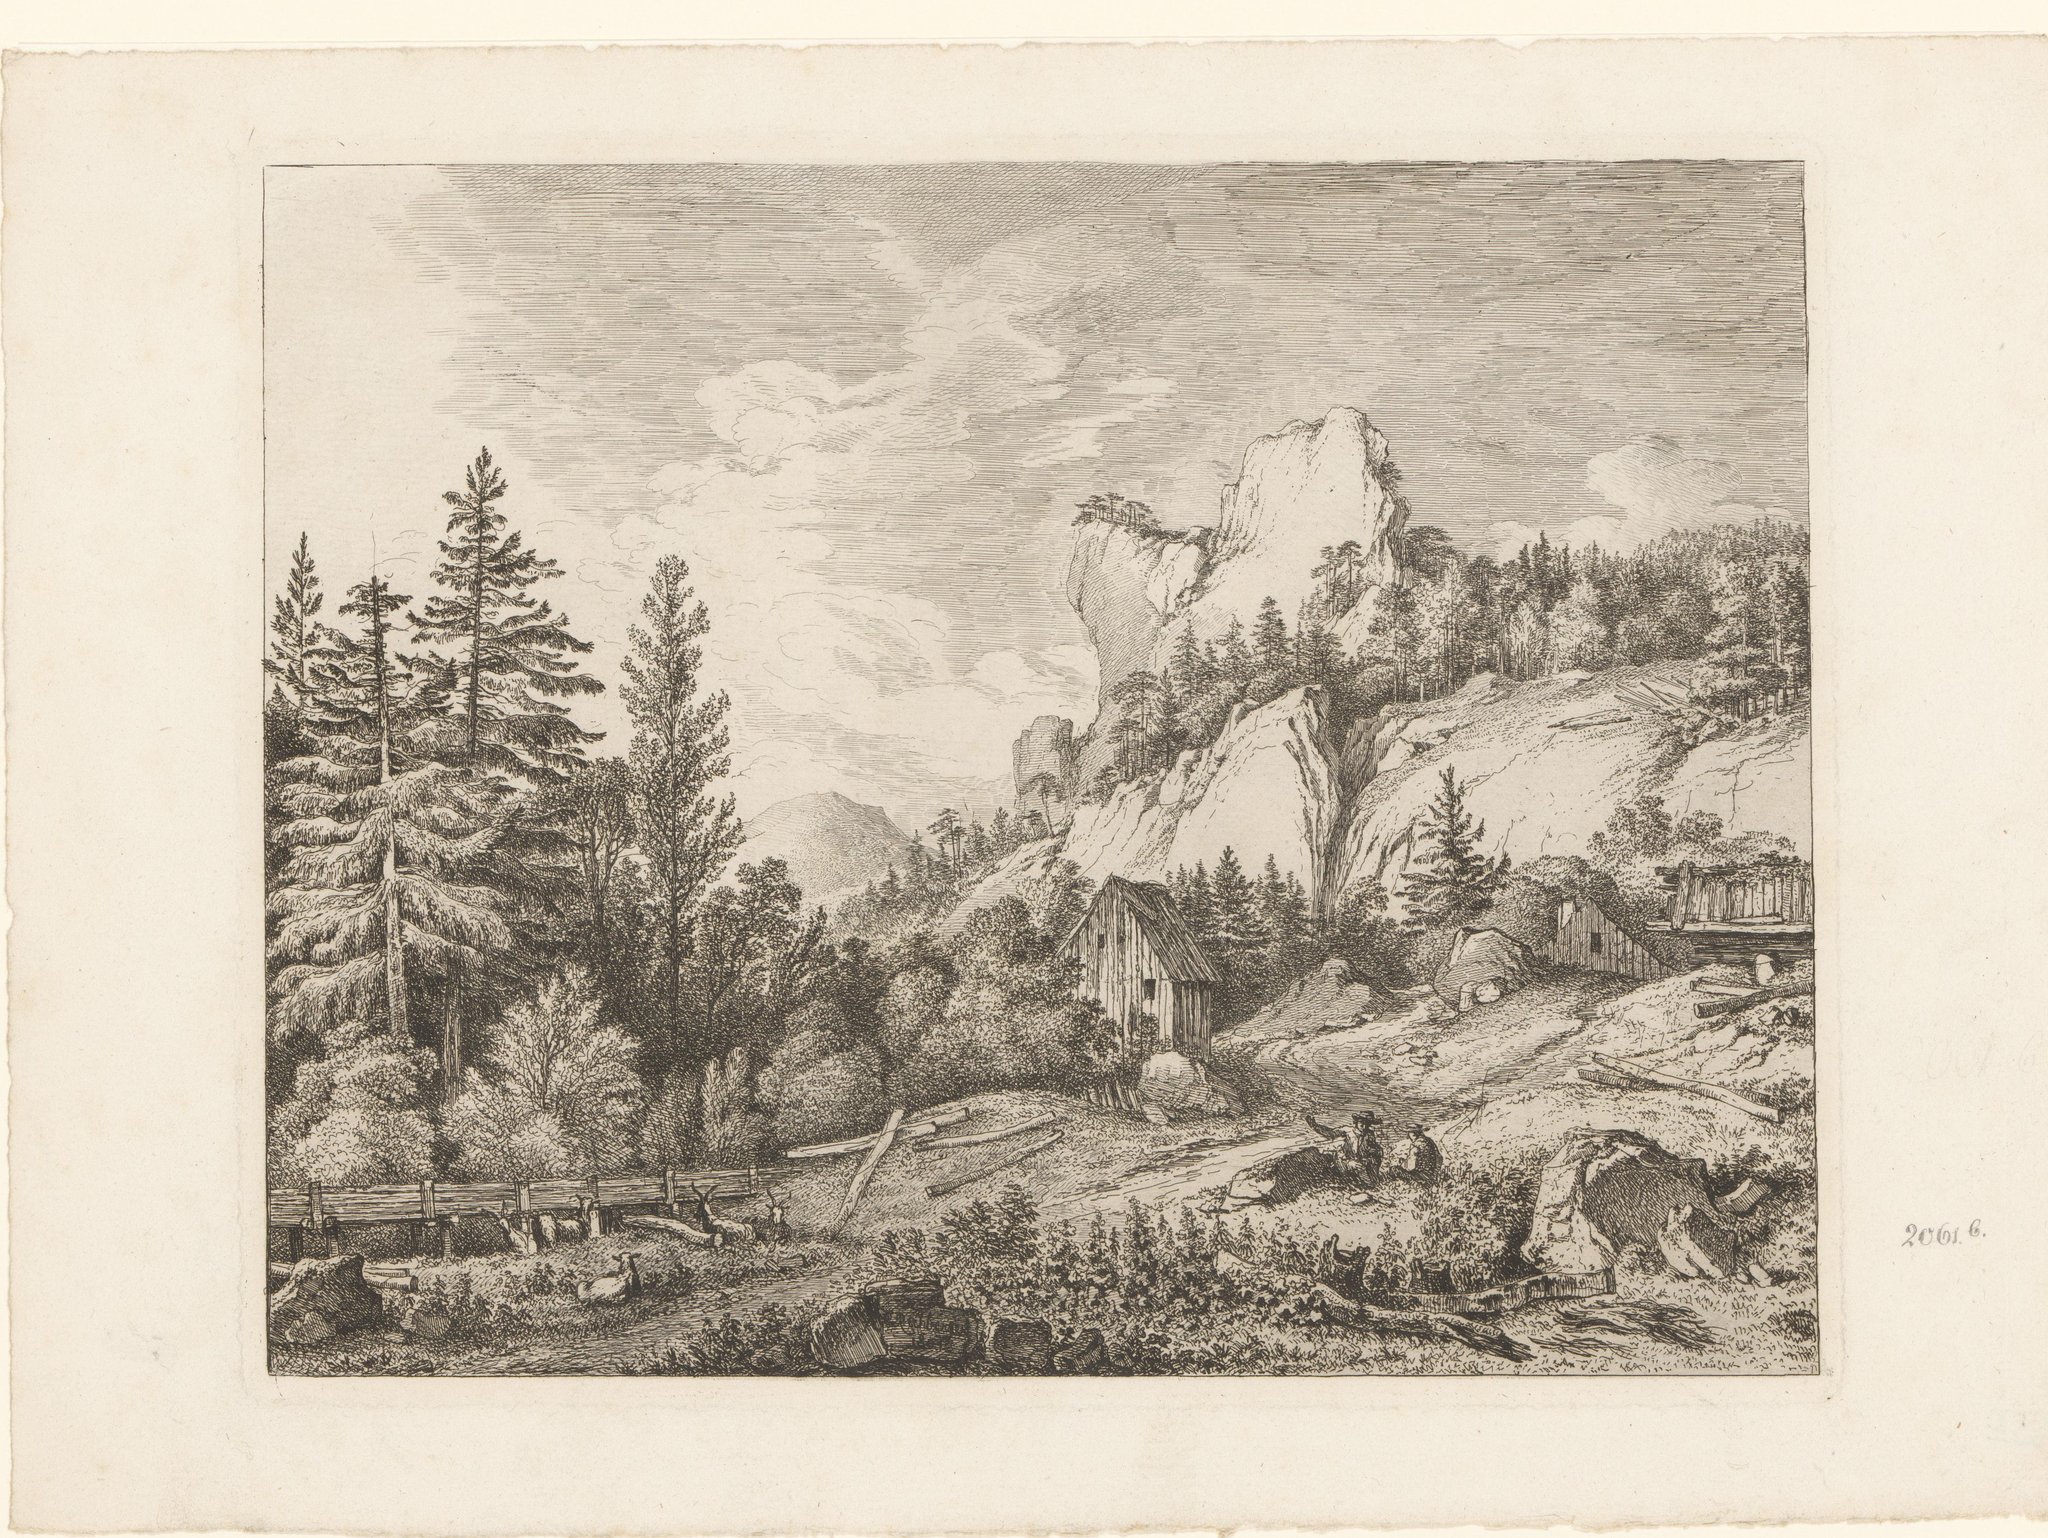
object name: print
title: Alpenlandschap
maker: franz rechberger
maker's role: painter, print maker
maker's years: 1771-1841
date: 1807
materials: paper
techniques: etching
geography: vienna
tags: mountain meadow, alp, mountains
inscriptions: collector's mark: Lugt 2228, collector's mark: Lugt 3976